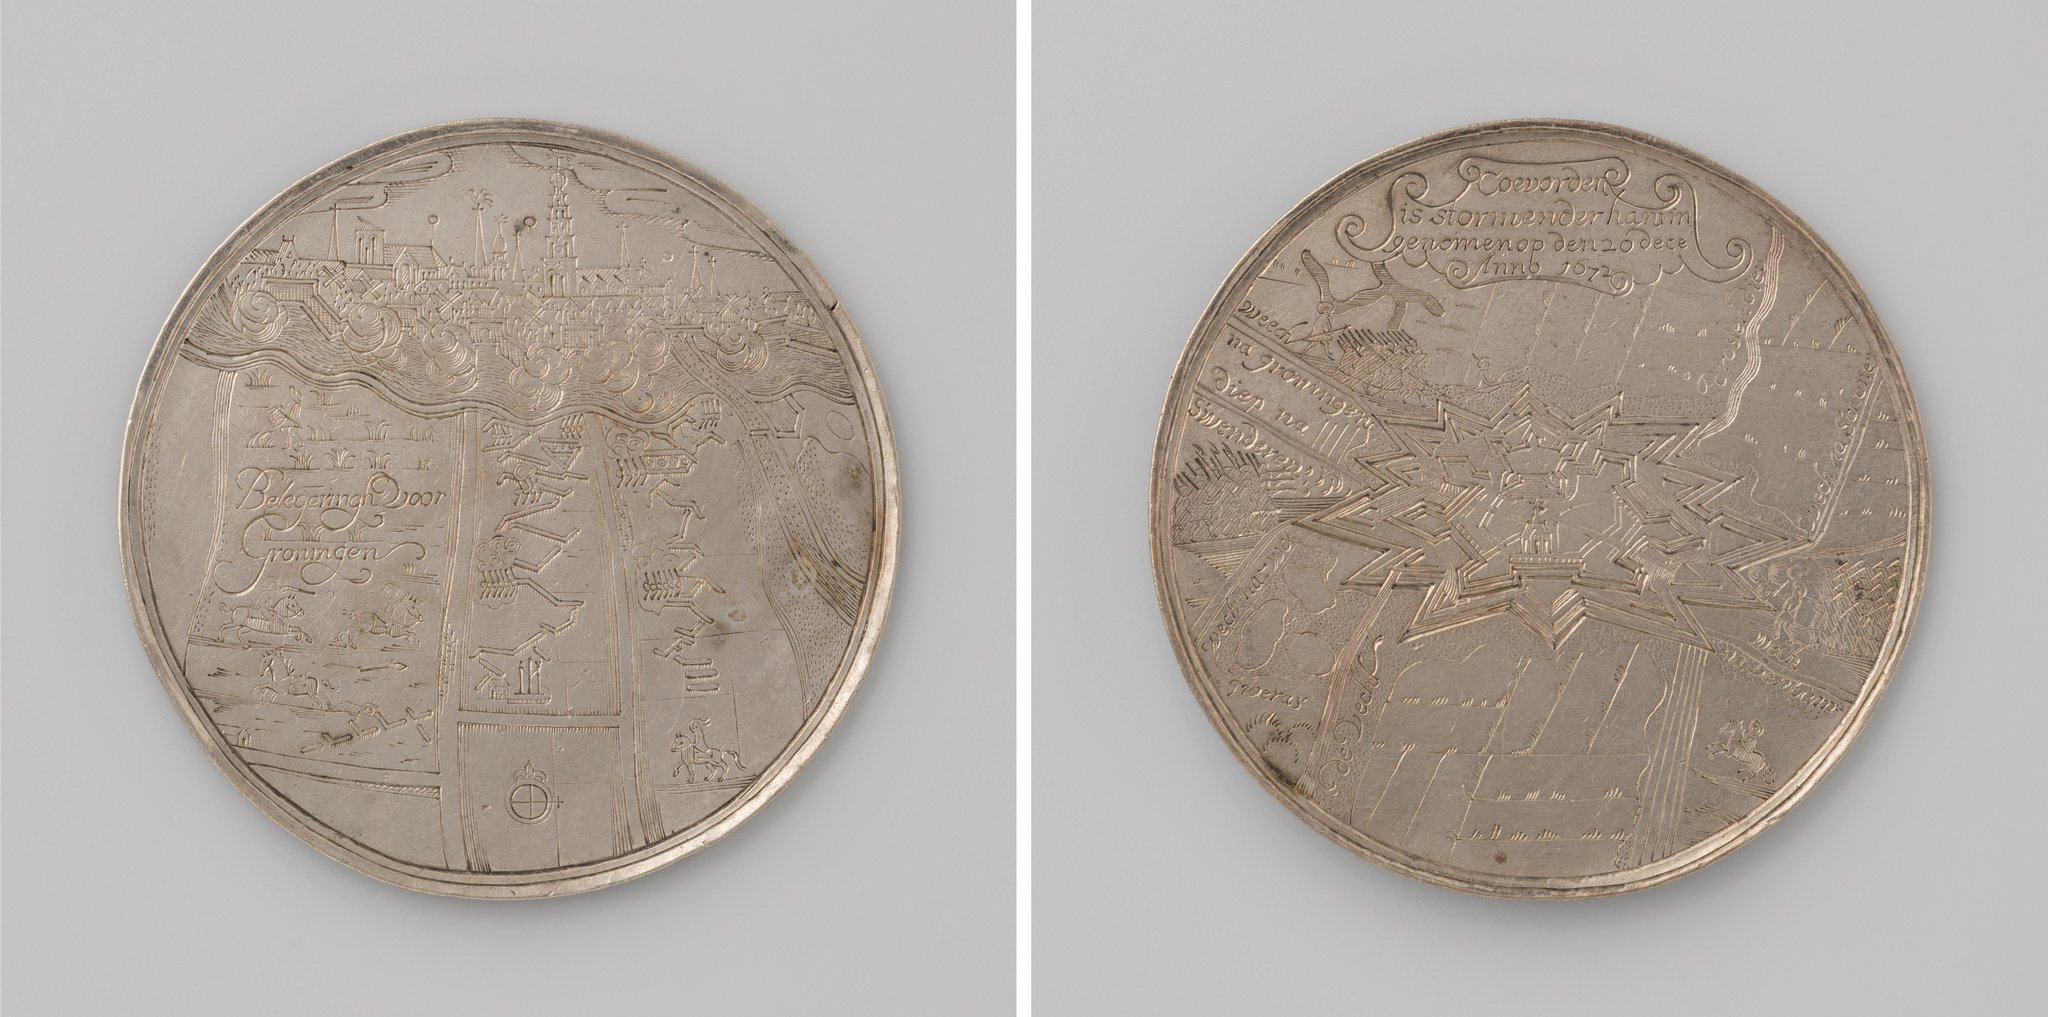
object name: insignia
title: Beleg van Groningen en het ontzet van Coevorden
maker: Anonymous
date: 1672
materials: silver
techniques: engraving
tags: rampjaar (disaster year)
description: Zilveren penning. Voorzijde: gezicht op stad en belegeraars met links midden opschrift. Keerzijde: plattegrond van stad onder opschrift.